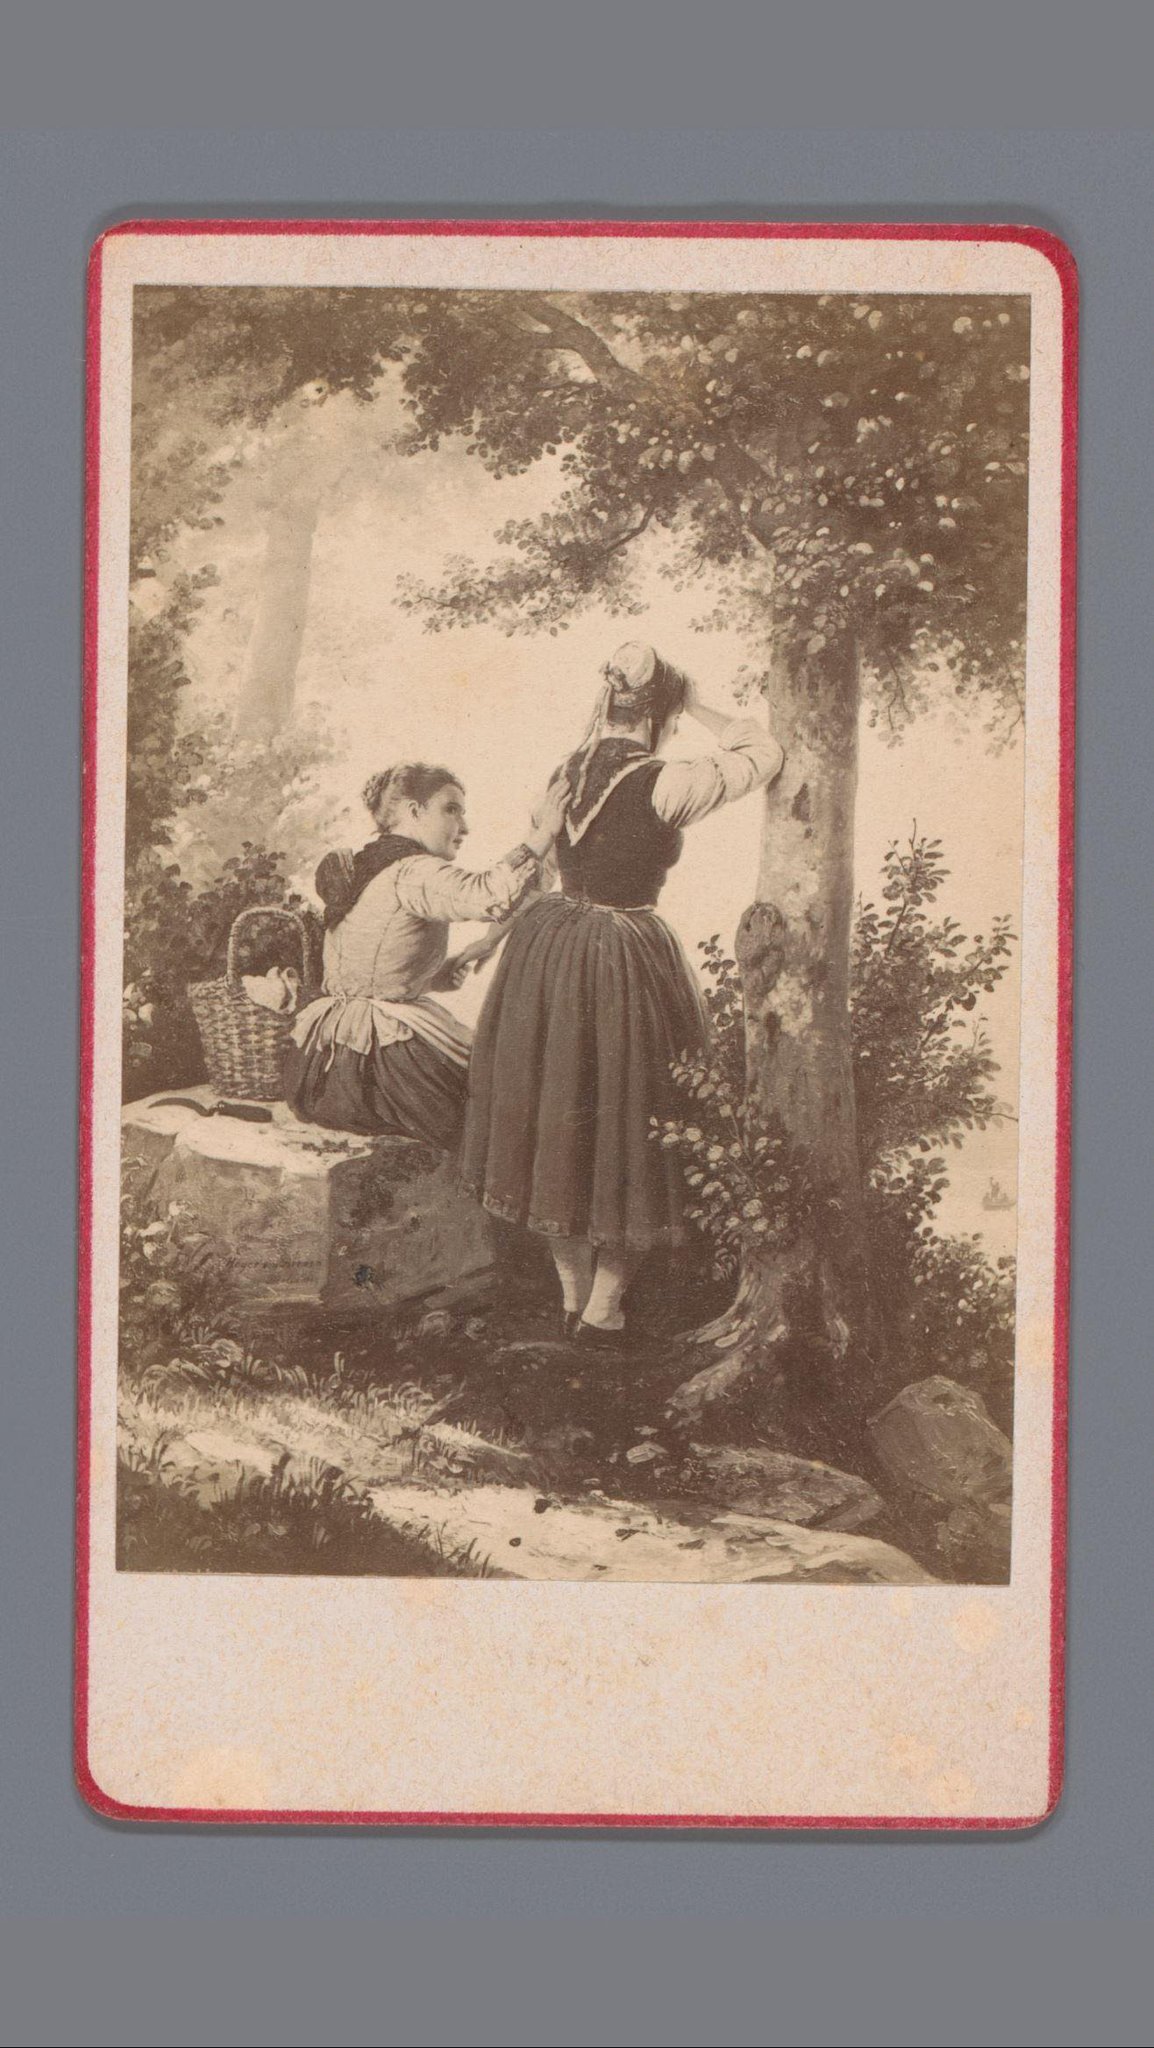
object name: carte de visite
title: Fotoreproductie van een schilderij van twee boerinnen van Johann Georg Meyer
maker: Anonymous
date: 1855-1885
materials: cardboard, paper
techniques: albumen print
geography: berlin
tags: adolescent, young woman, maiden, hand on shoulder (friends)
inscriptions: inscription: ‘Kunst-Verlag/ der Photographischen Gesellschaft/ Berlin/ am Dönhofsplatz.’